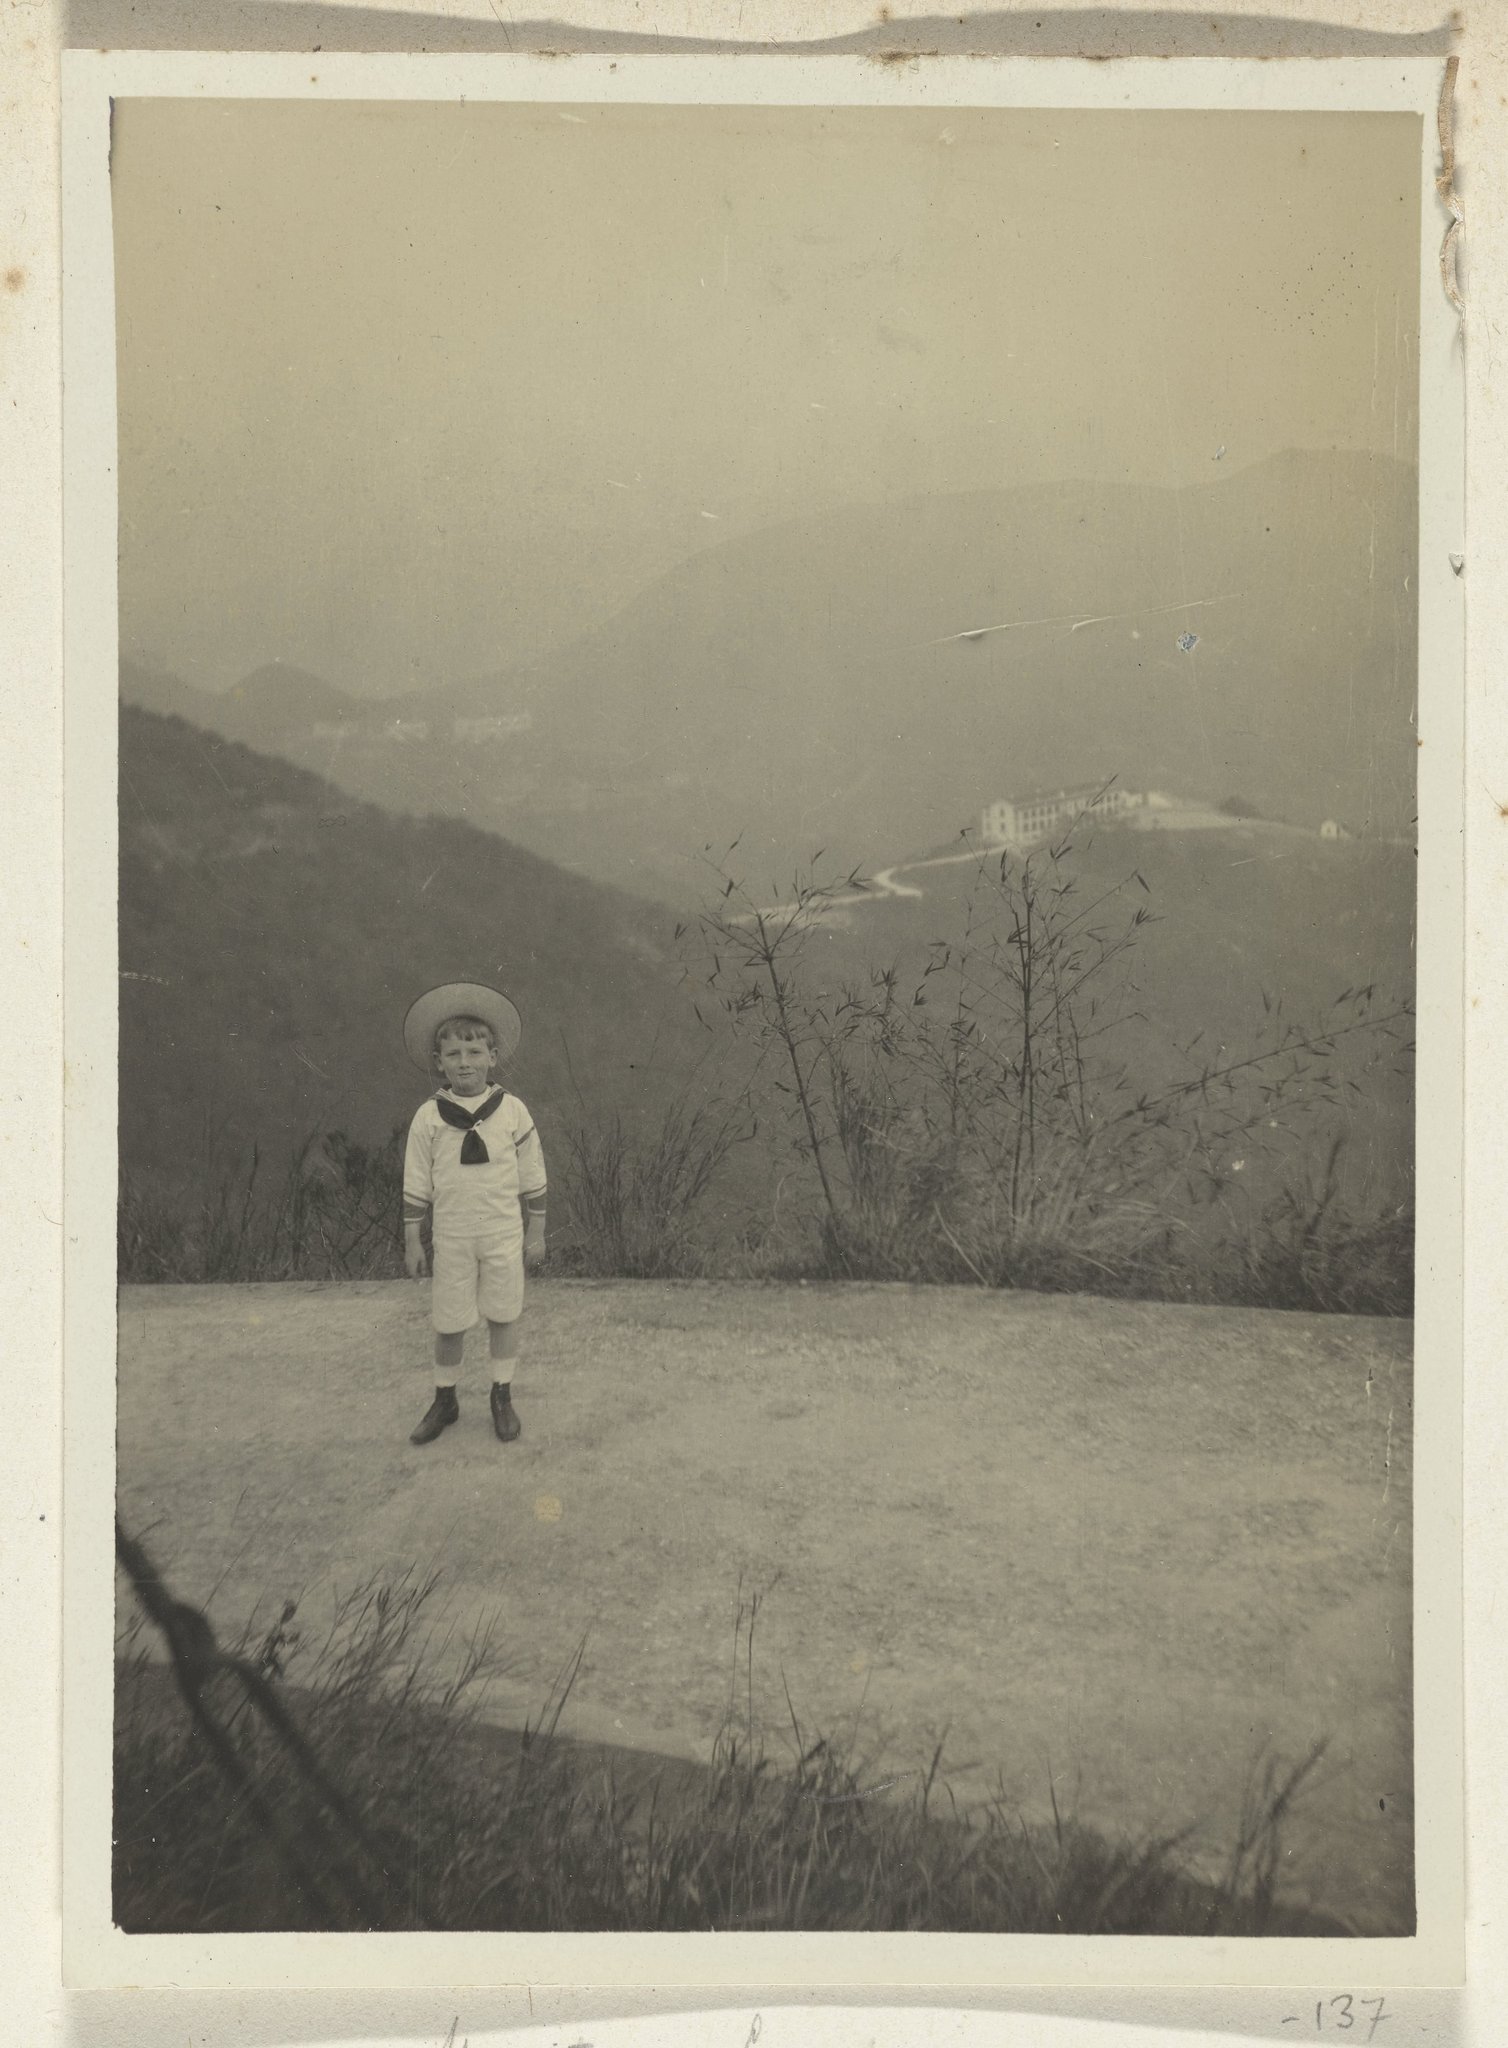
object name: photograph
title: Master Luykx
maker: geldolph adriaan kessler (dolph)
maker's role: fotograaf, industrieel, voetballer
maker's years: 1884-1945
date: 1903-1908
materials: cardboard, photographic support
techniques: gelatin silver print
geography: hong kong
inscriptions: title: ‘H.W. Boerner's Hong Kong’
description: Portret van een jongen in matrozenpak 'Master Luykx', Hong Kong. Onderdeel van het fotoalbum van Dolph Kessler met opnamen die hij maakte tijdens zijn verblijf in Engeland en op een wereldreis die hij als secretaris van Henri Deterding (directeur Koninklijke Olie) ondernam naar Nederlands-Indië, Japan, China en de Verenigde Staten, tussen 1906 en 1908.